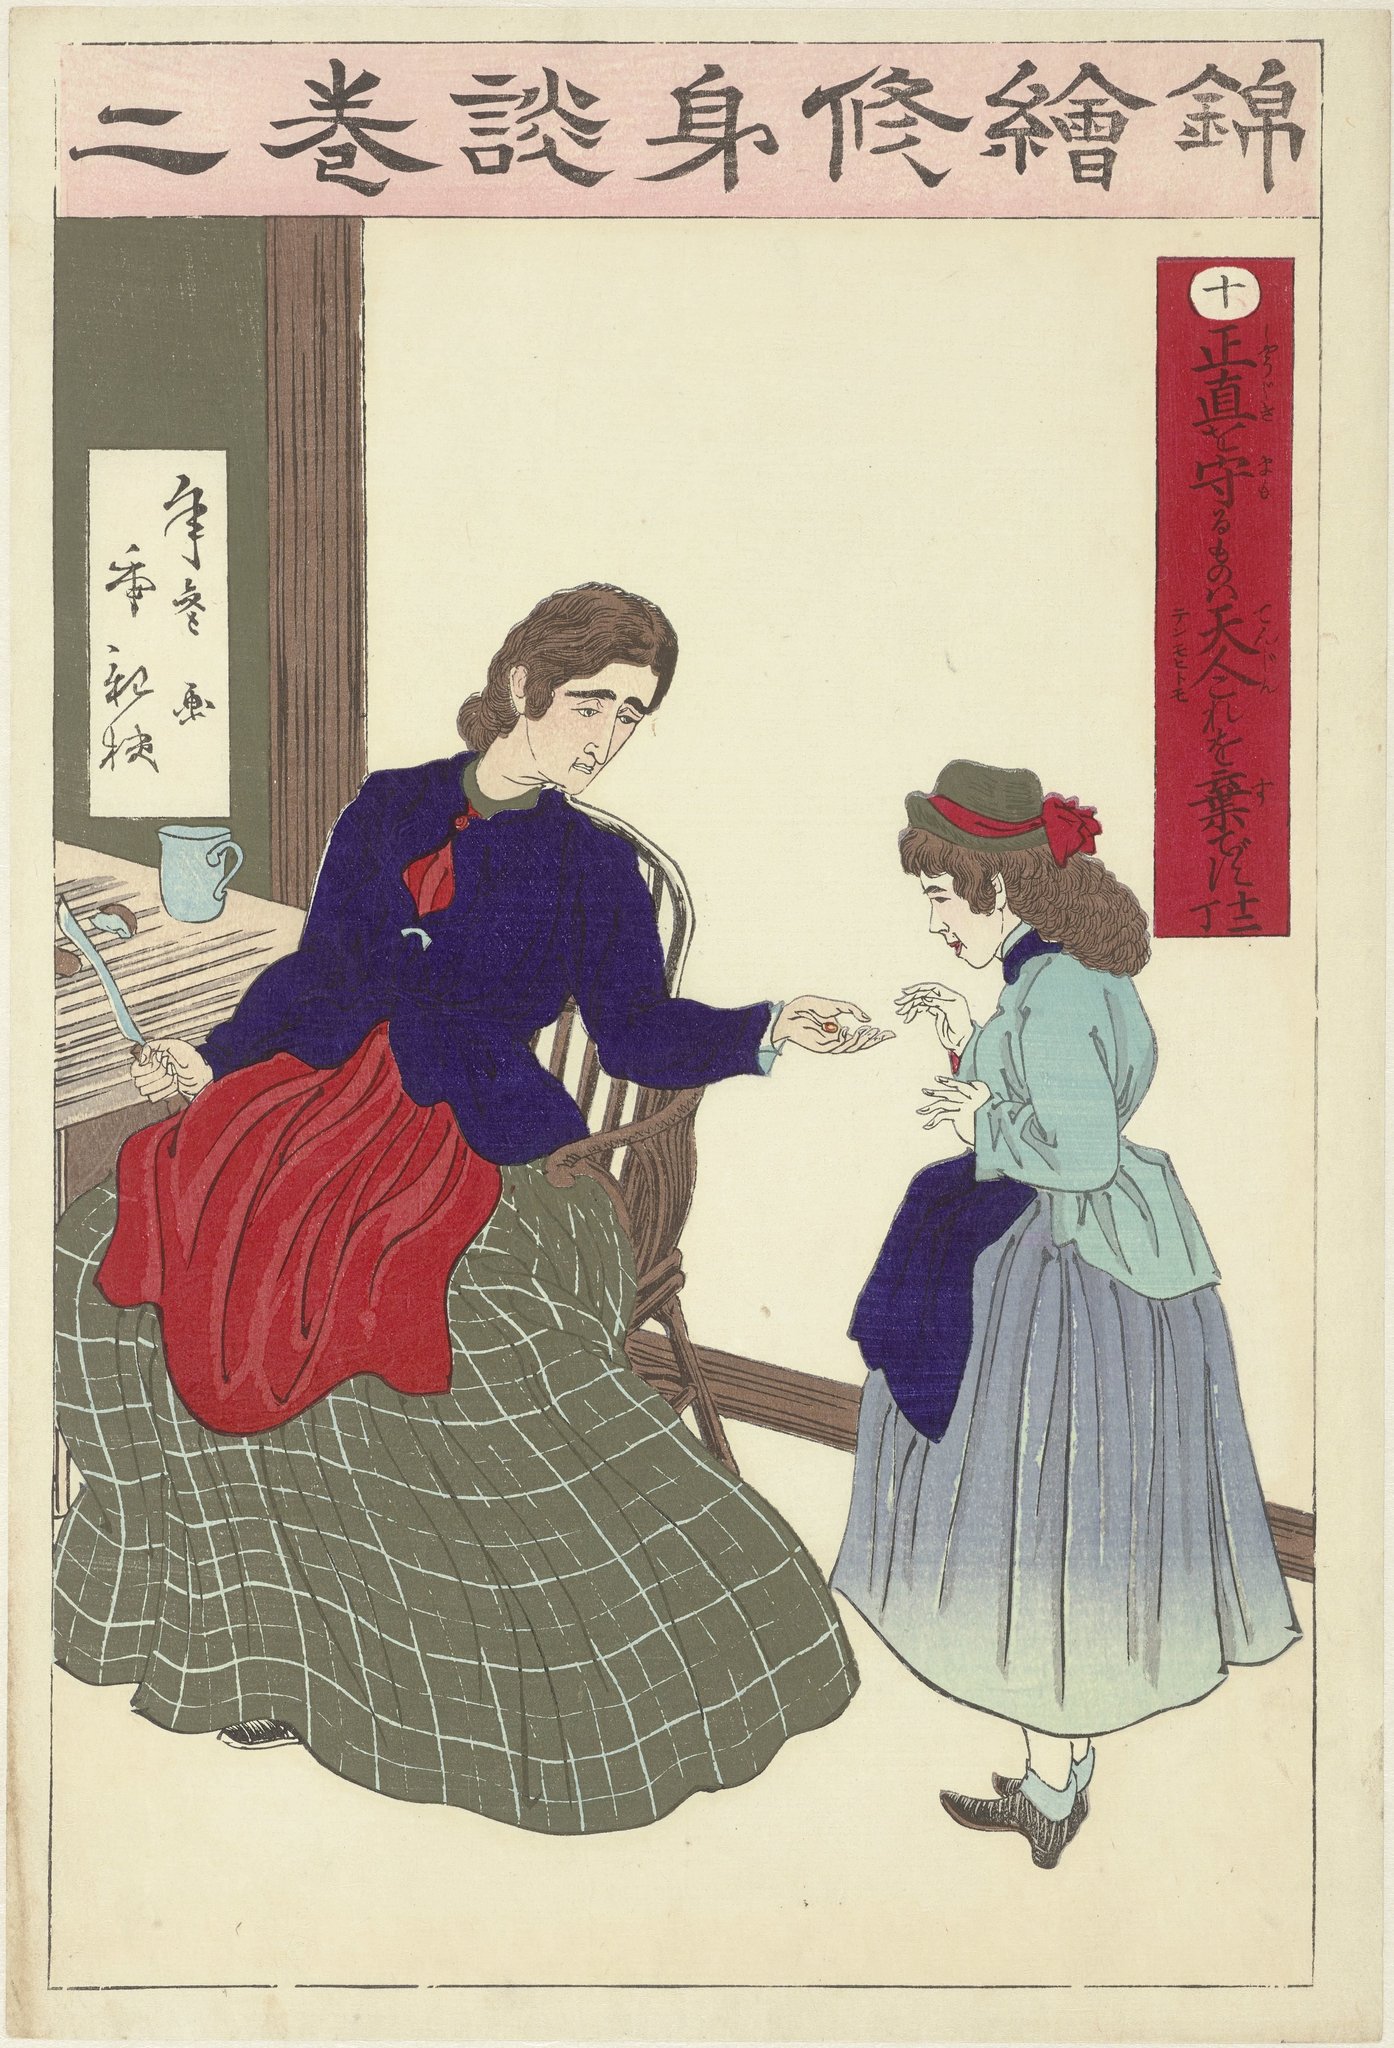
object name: print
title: Eerlijkheid duurt het langst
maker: kobayashi toshimitsu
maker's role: print maker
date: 1850-1870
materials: paper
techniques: woodcut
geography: japan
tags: mother and daughter(s) (family group)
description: Een moeder zit aan tafel en geeft een muntstuk aan haar dochter. Nummer tien uit een serie over westerse zeden. (Yokohama-e).